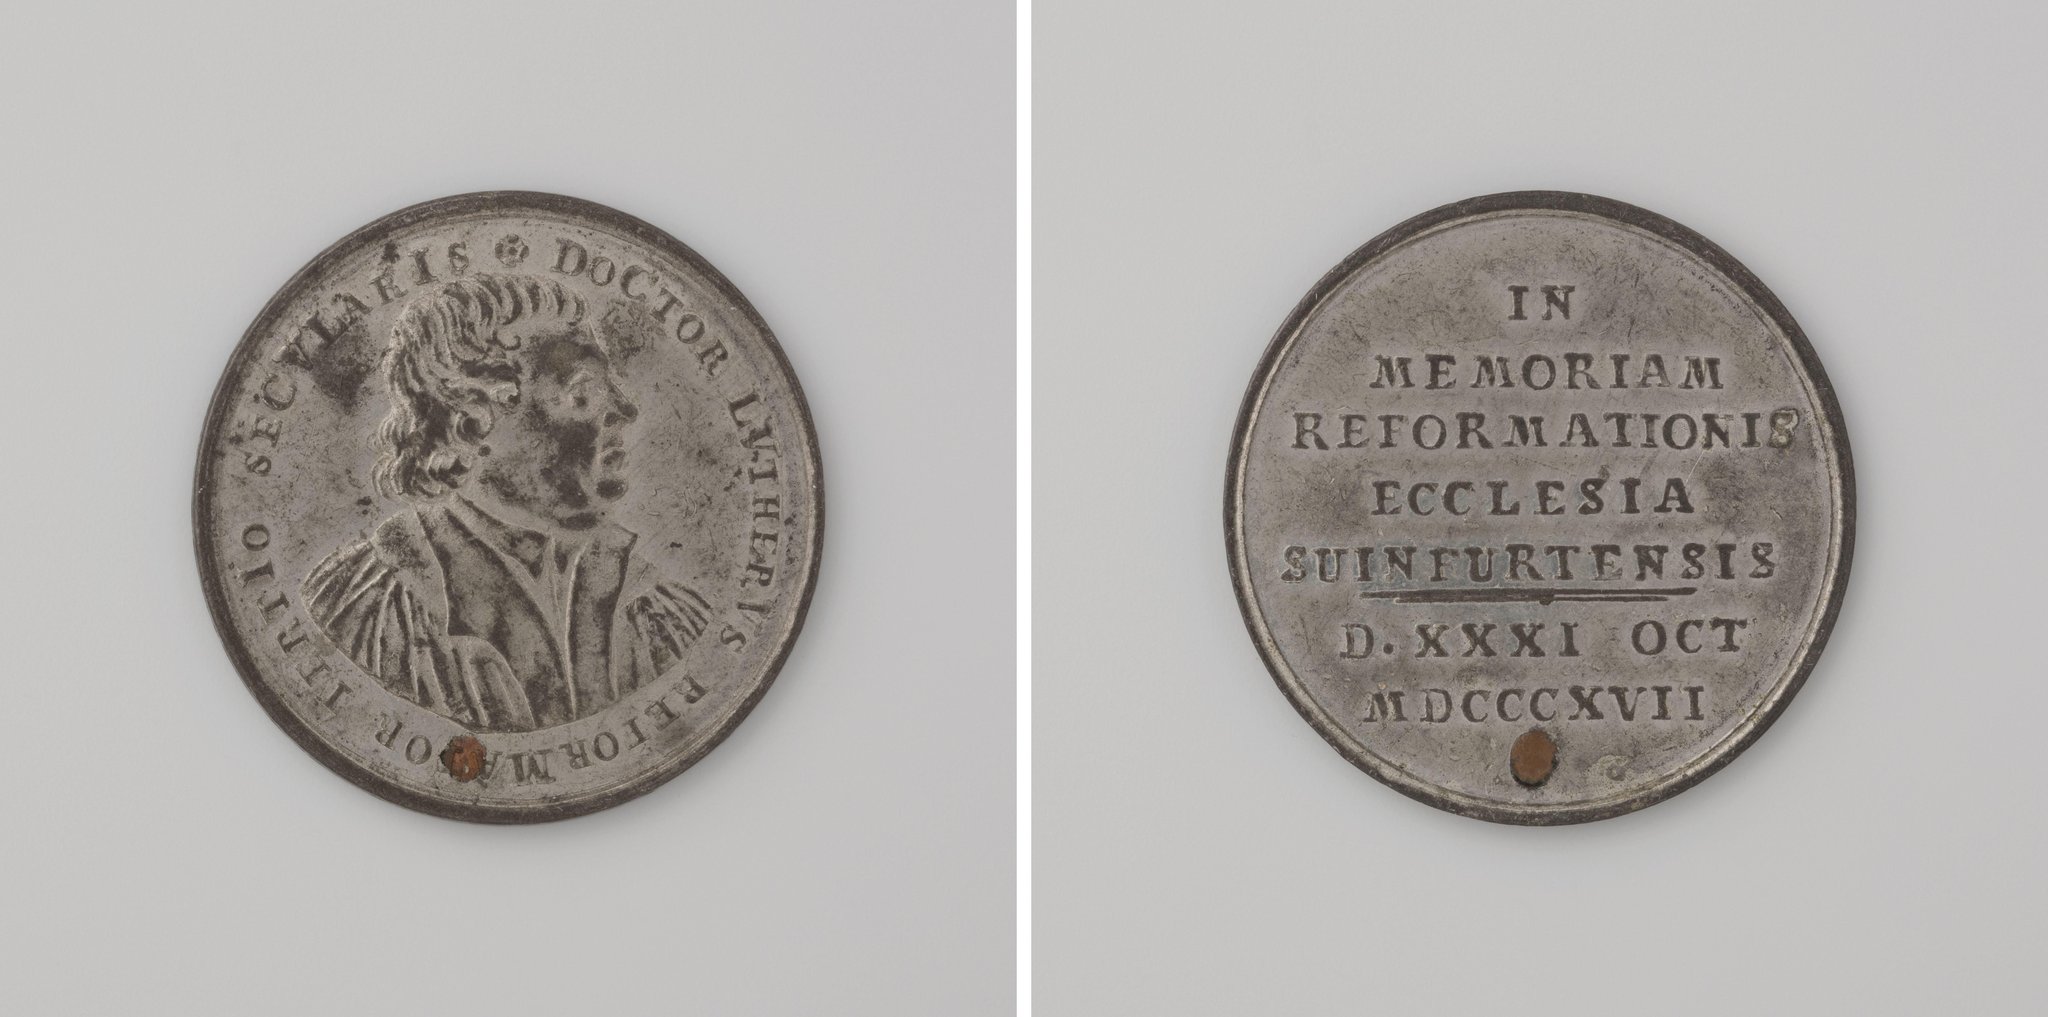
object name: history medal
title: Derde eeuwfeest van de Reformatie, te Schweinfurt gevierd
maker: Anonymous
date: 1817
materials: silver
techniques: striking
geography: germany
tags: priest, martin luther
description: Zilveren penning. Voorzijde: borststuk man binnen omschrift. Keerzijde: opschrift